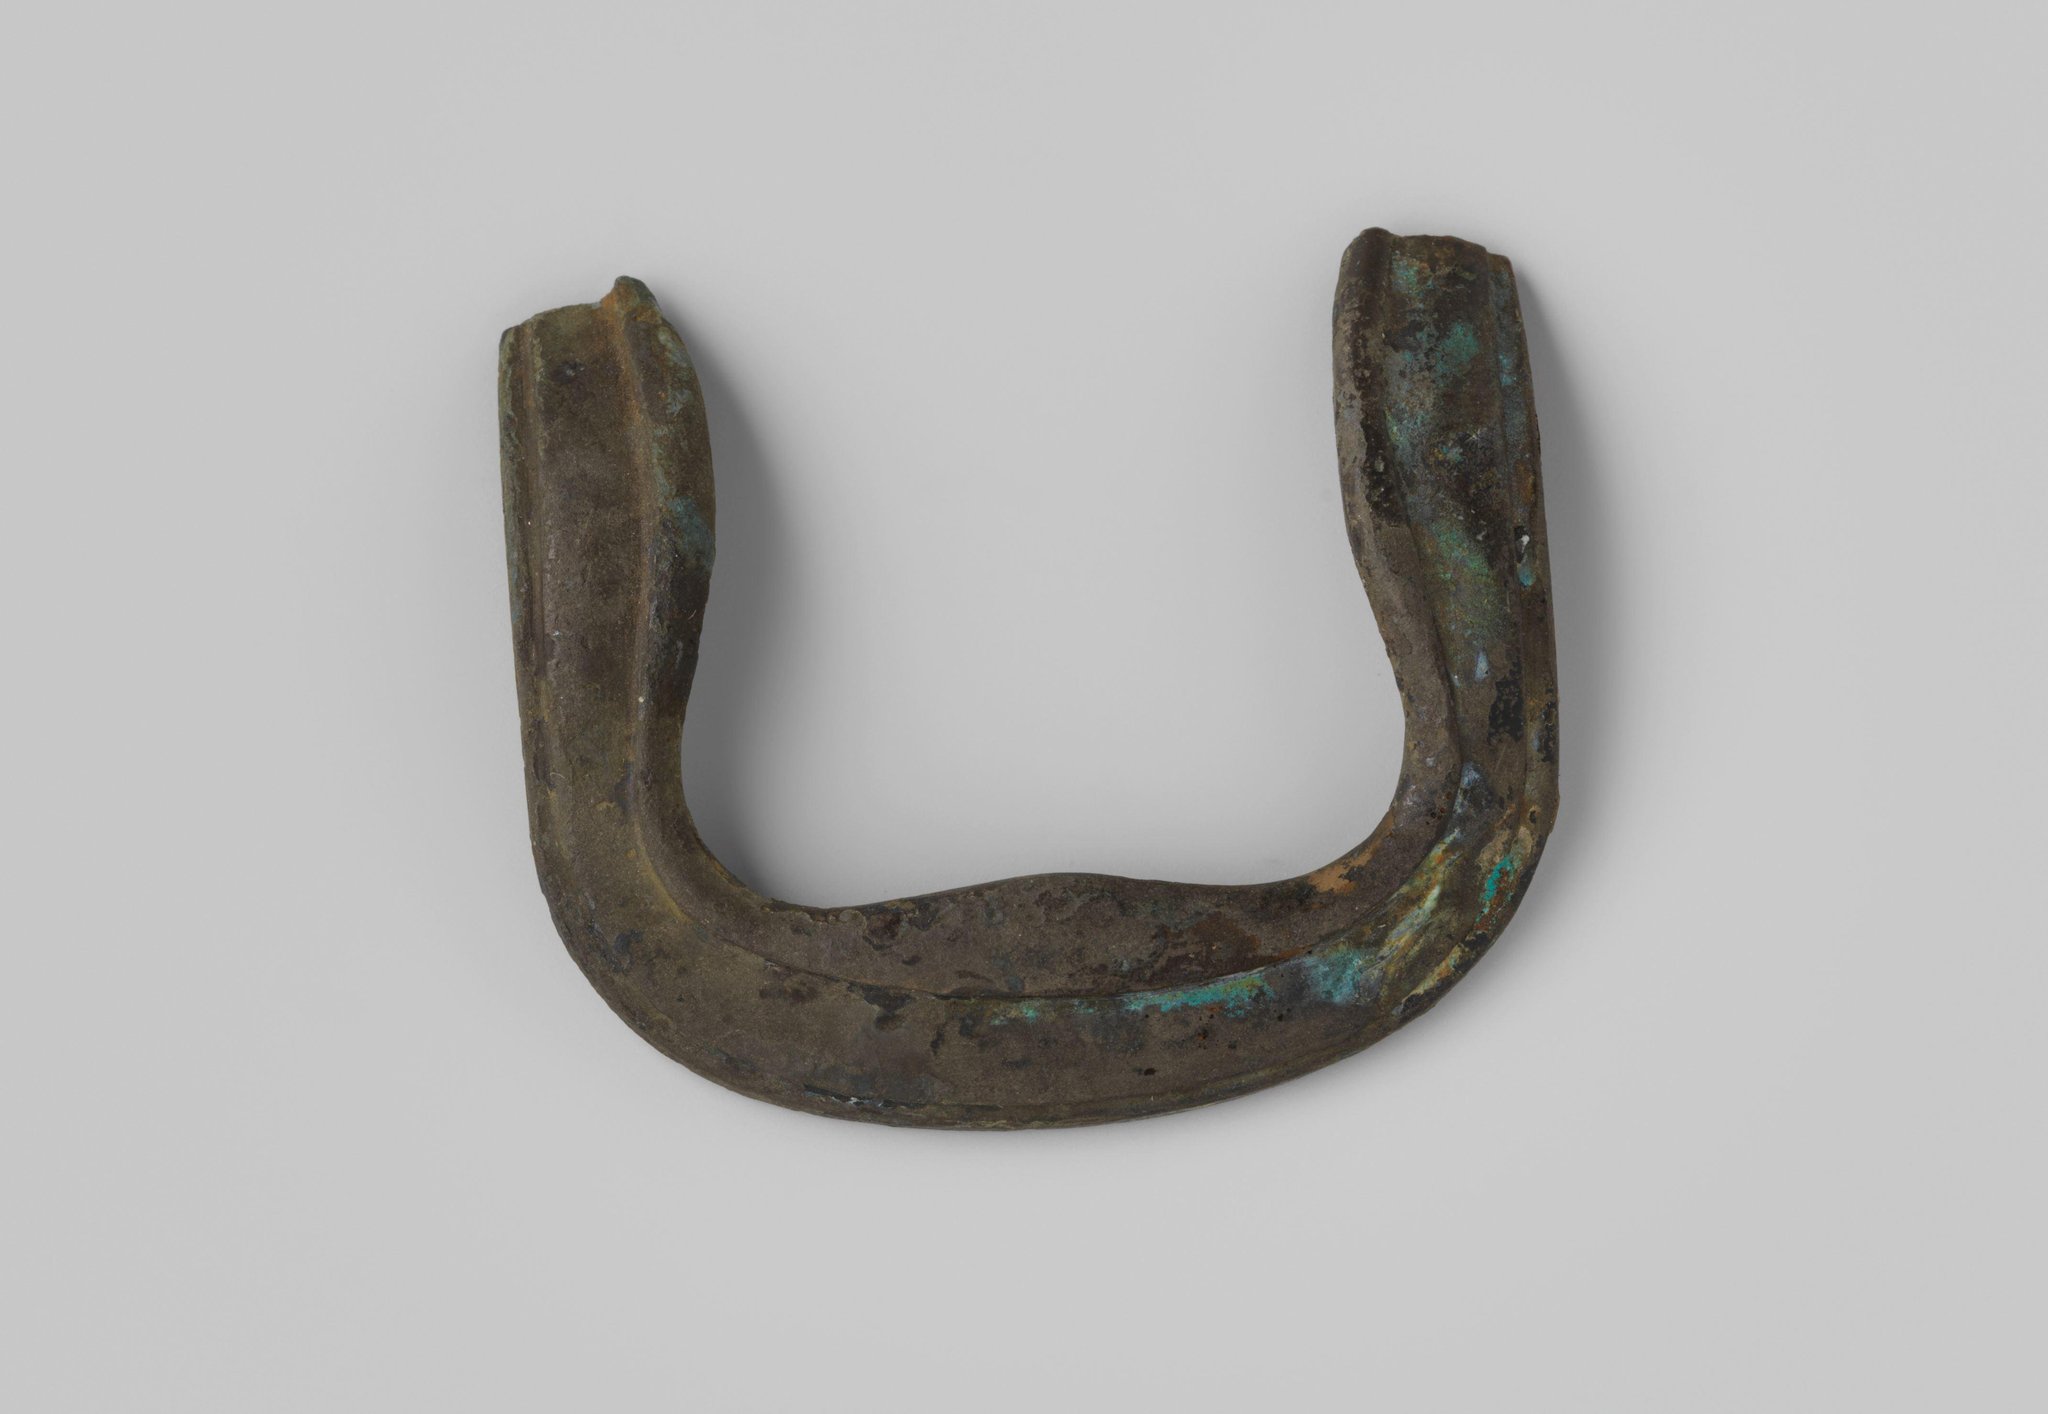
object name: shoe buckle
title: Fragment schoengesp uit het wrak van de Oost-Indiëvaarder Hollandia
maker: Anonymous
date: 1700-1743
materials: silver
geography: netherlands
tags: verenigde oostindische compagnie, hollandia (schip), annet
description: Buckle, chape buckle, shoe buckle; fragm, half ring, moulding id. NG 1980-27H2104.